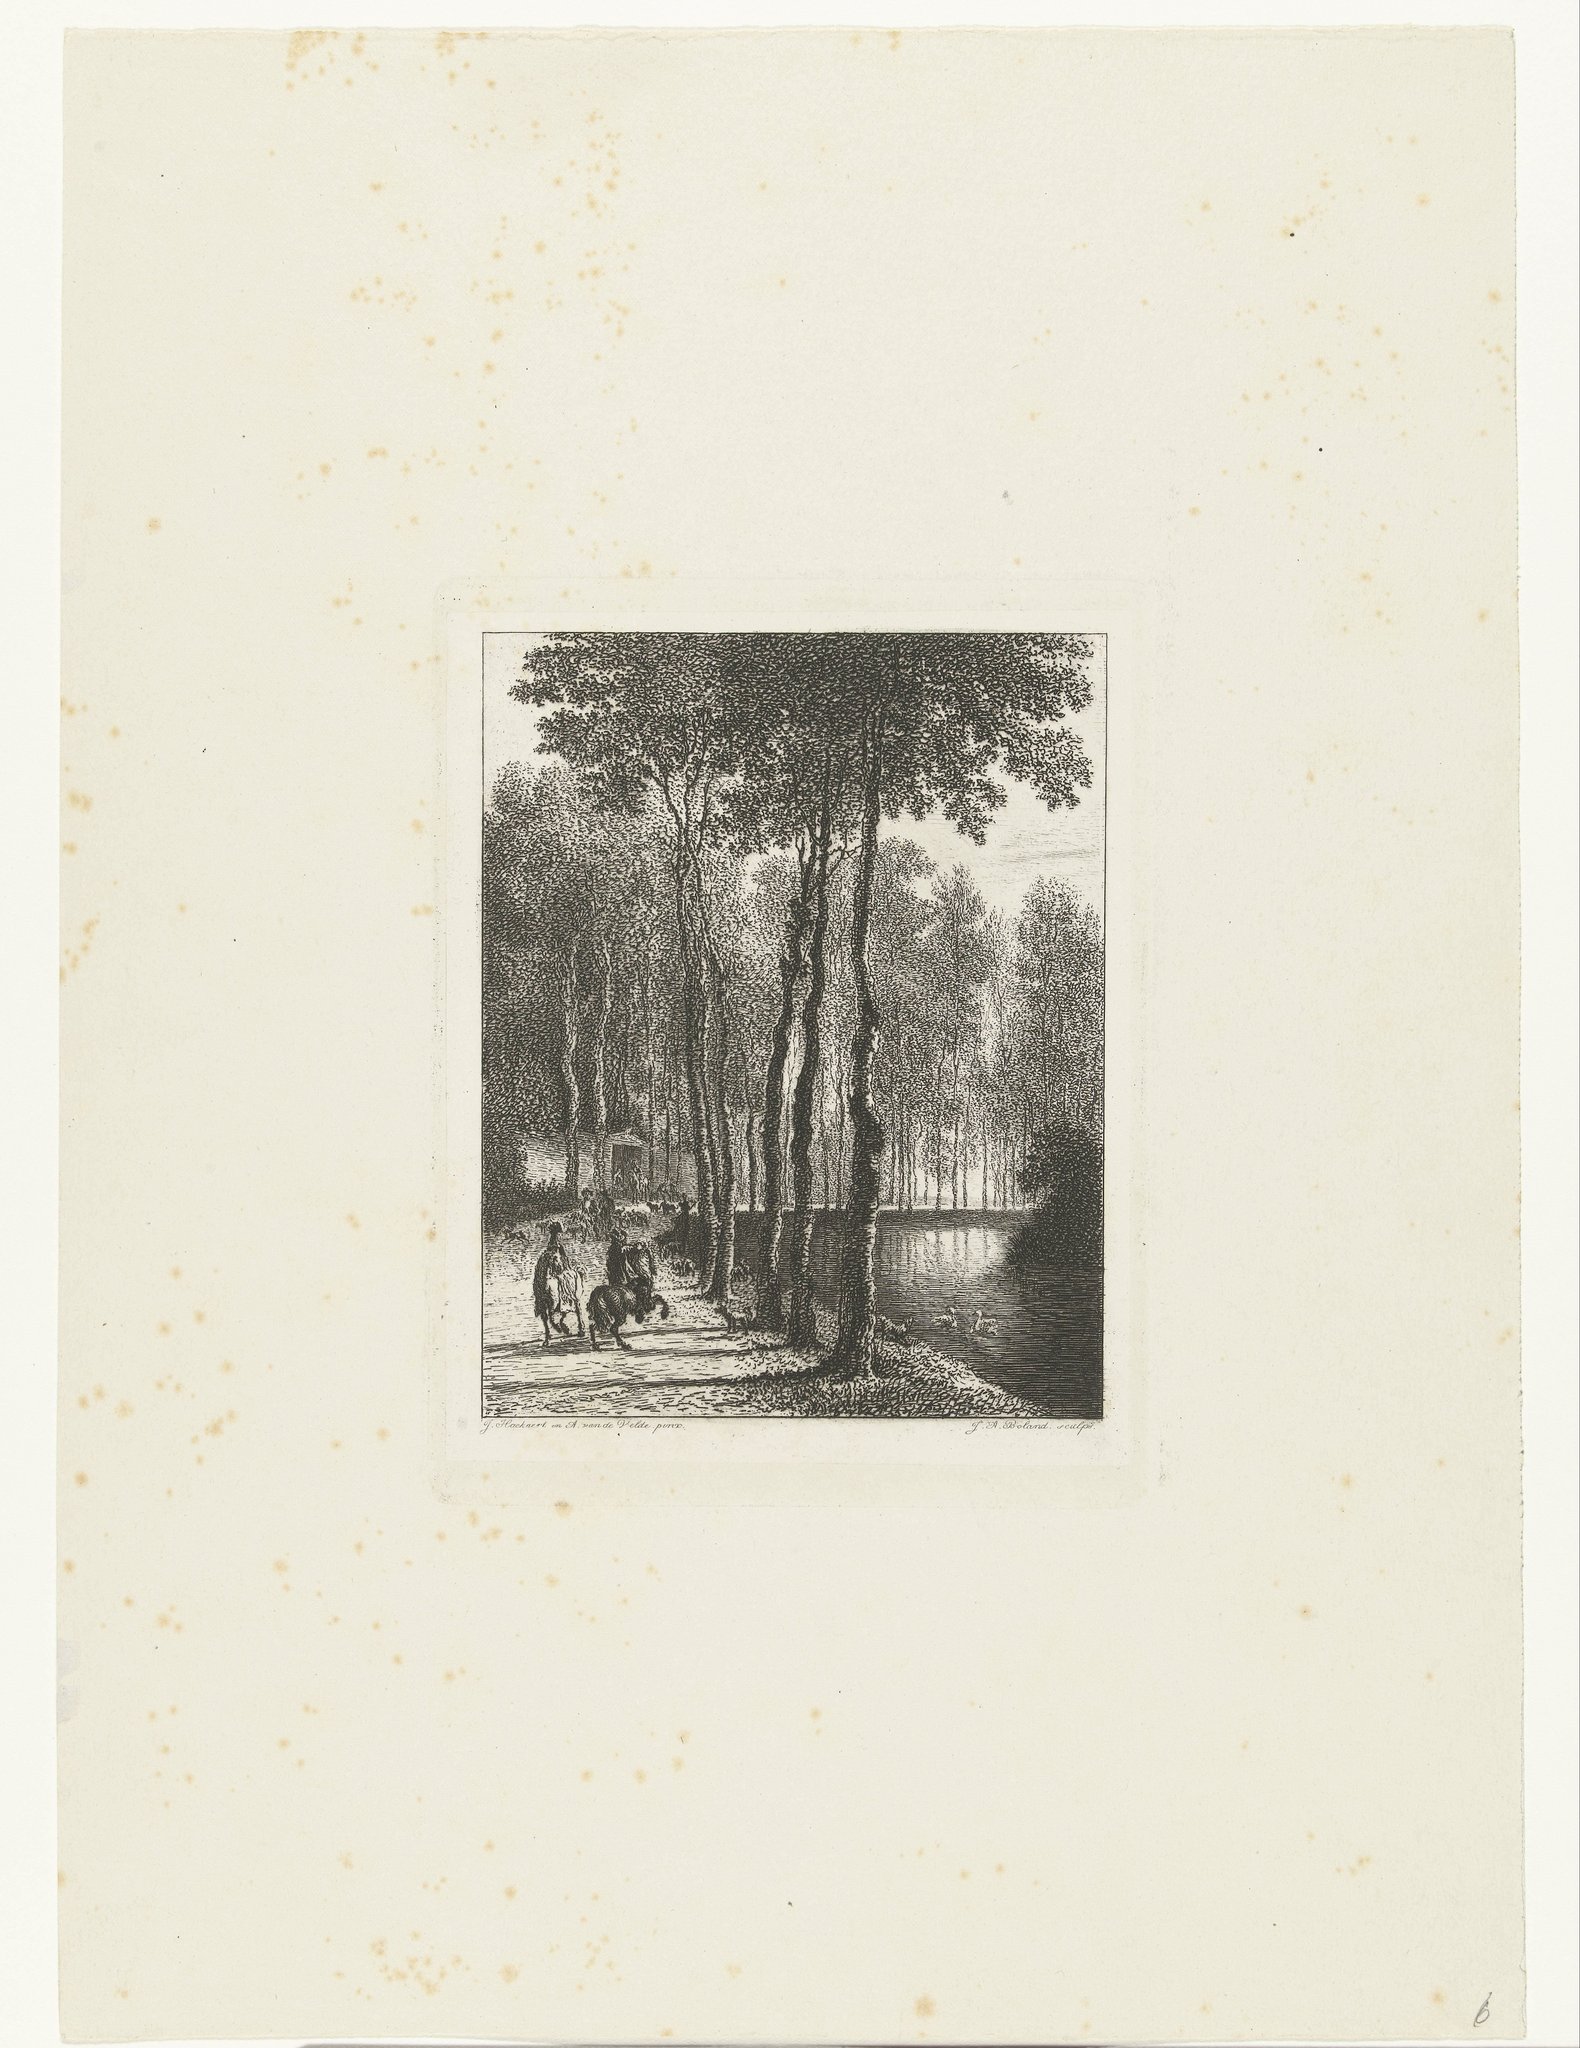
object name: print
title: De berkenlaan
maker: johannes arnoldus boland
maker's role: print maker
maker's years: 1838-1922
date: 1860-1900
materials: paper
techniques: etching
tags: lane, alley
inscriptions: collector's mark: Lugt 2228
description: Coll. de la Faille. Reproductie van een schilderij uit de collectie van het Rijksmuseum Amsterdam, SK-A-130.